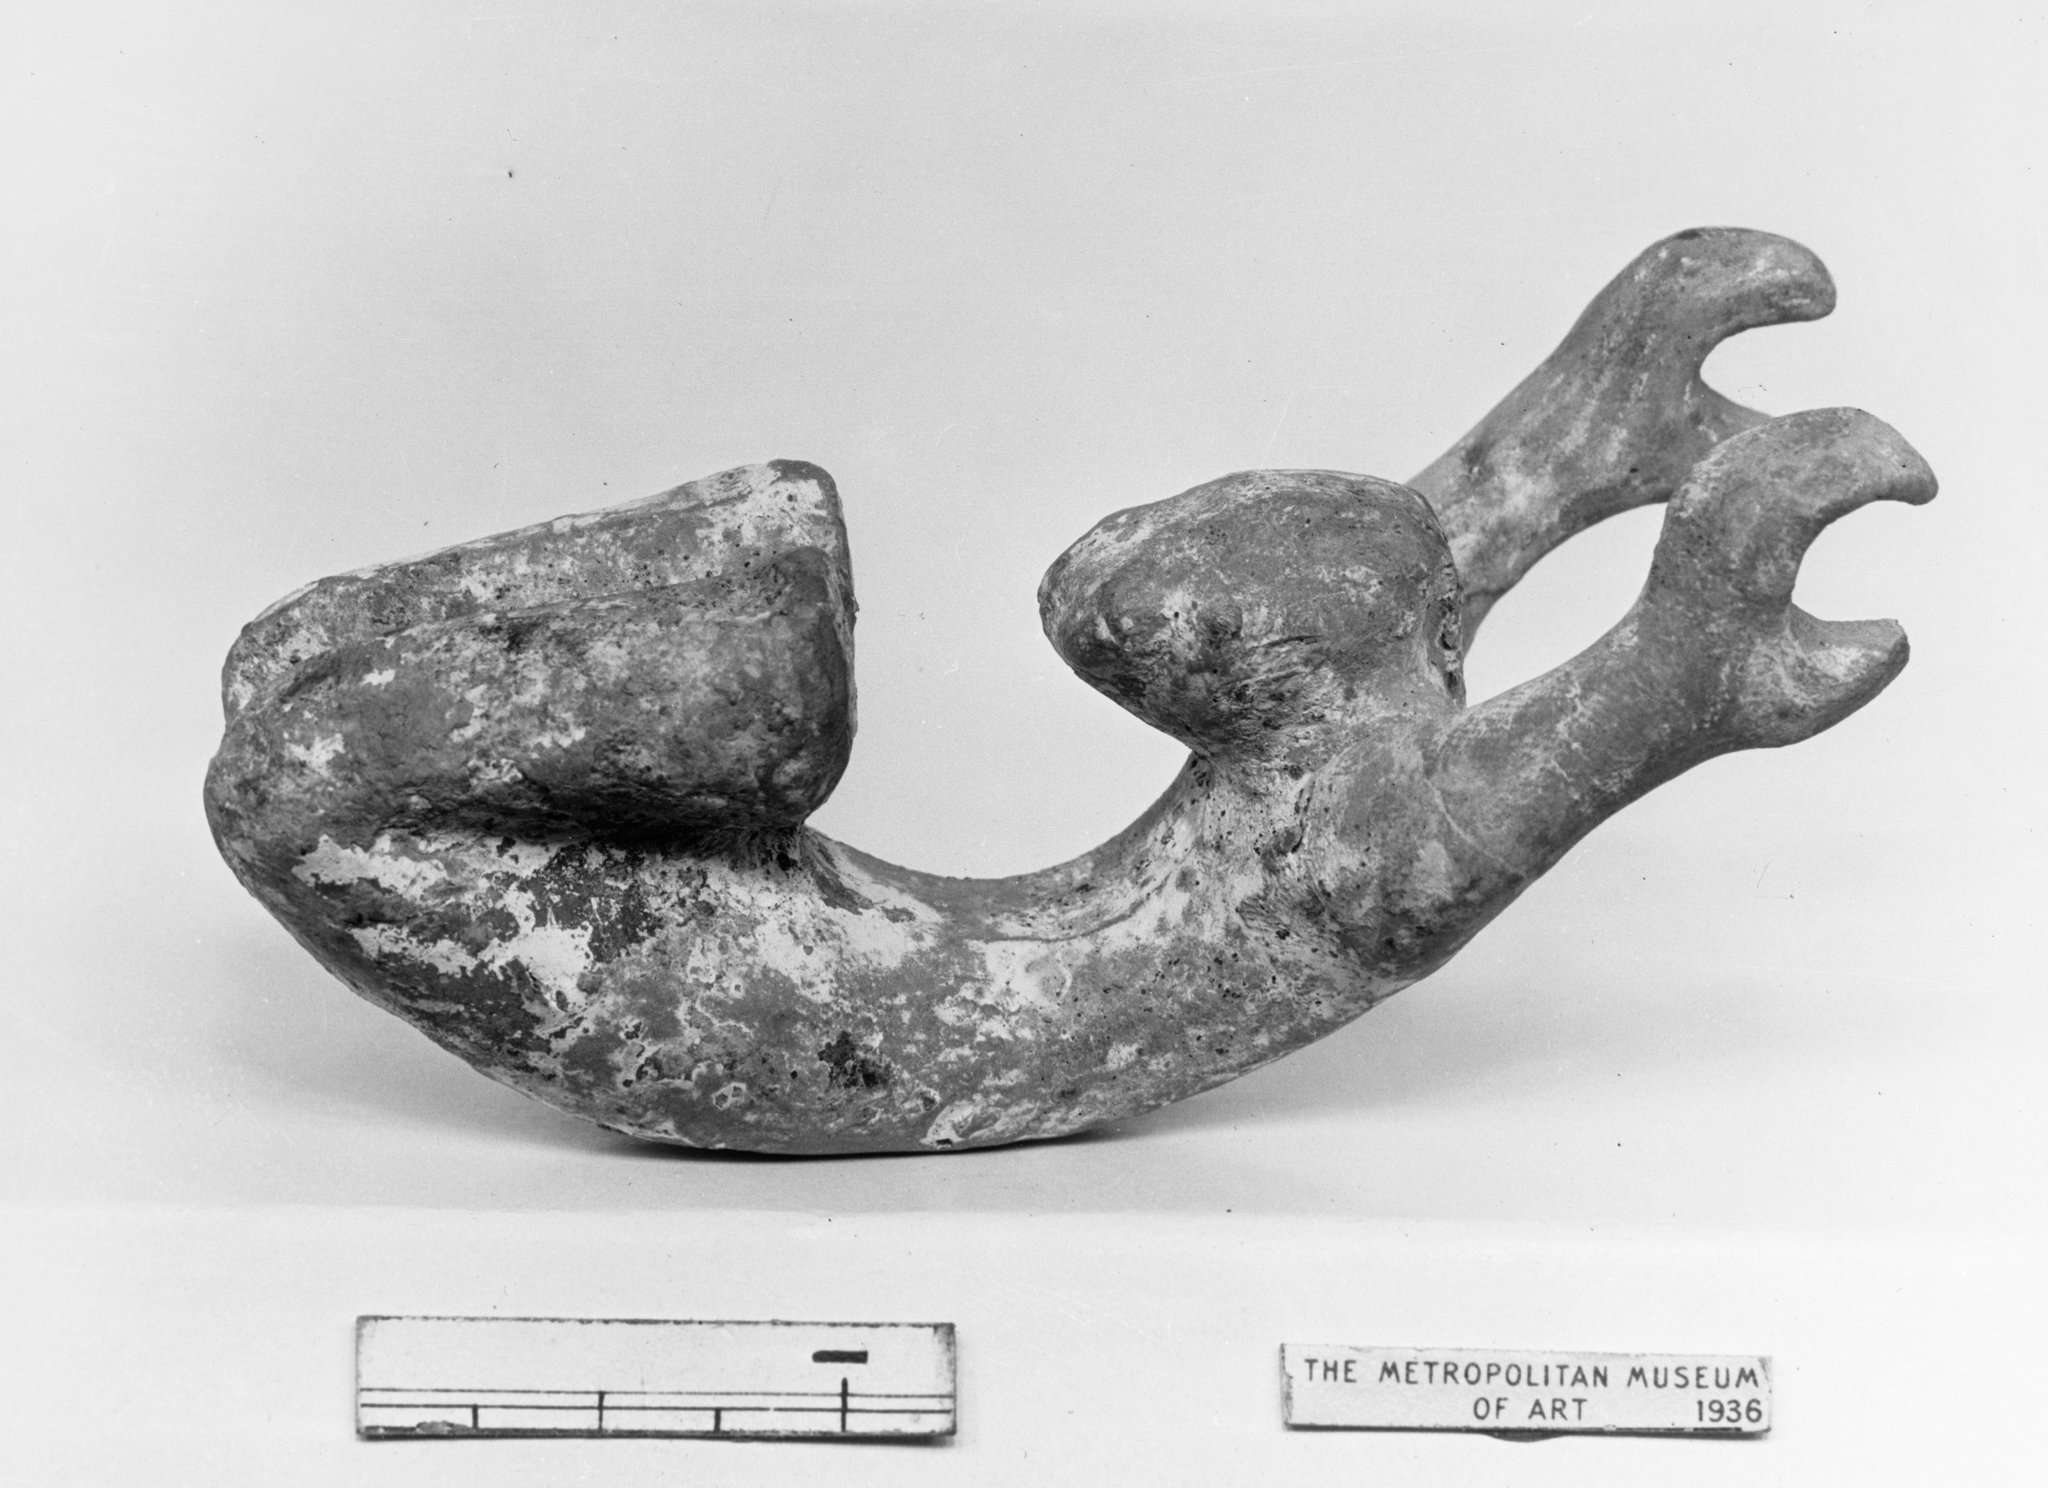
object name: tomb figure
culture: chinese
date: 206 BCE-220 CE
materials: pottery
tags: acrobats